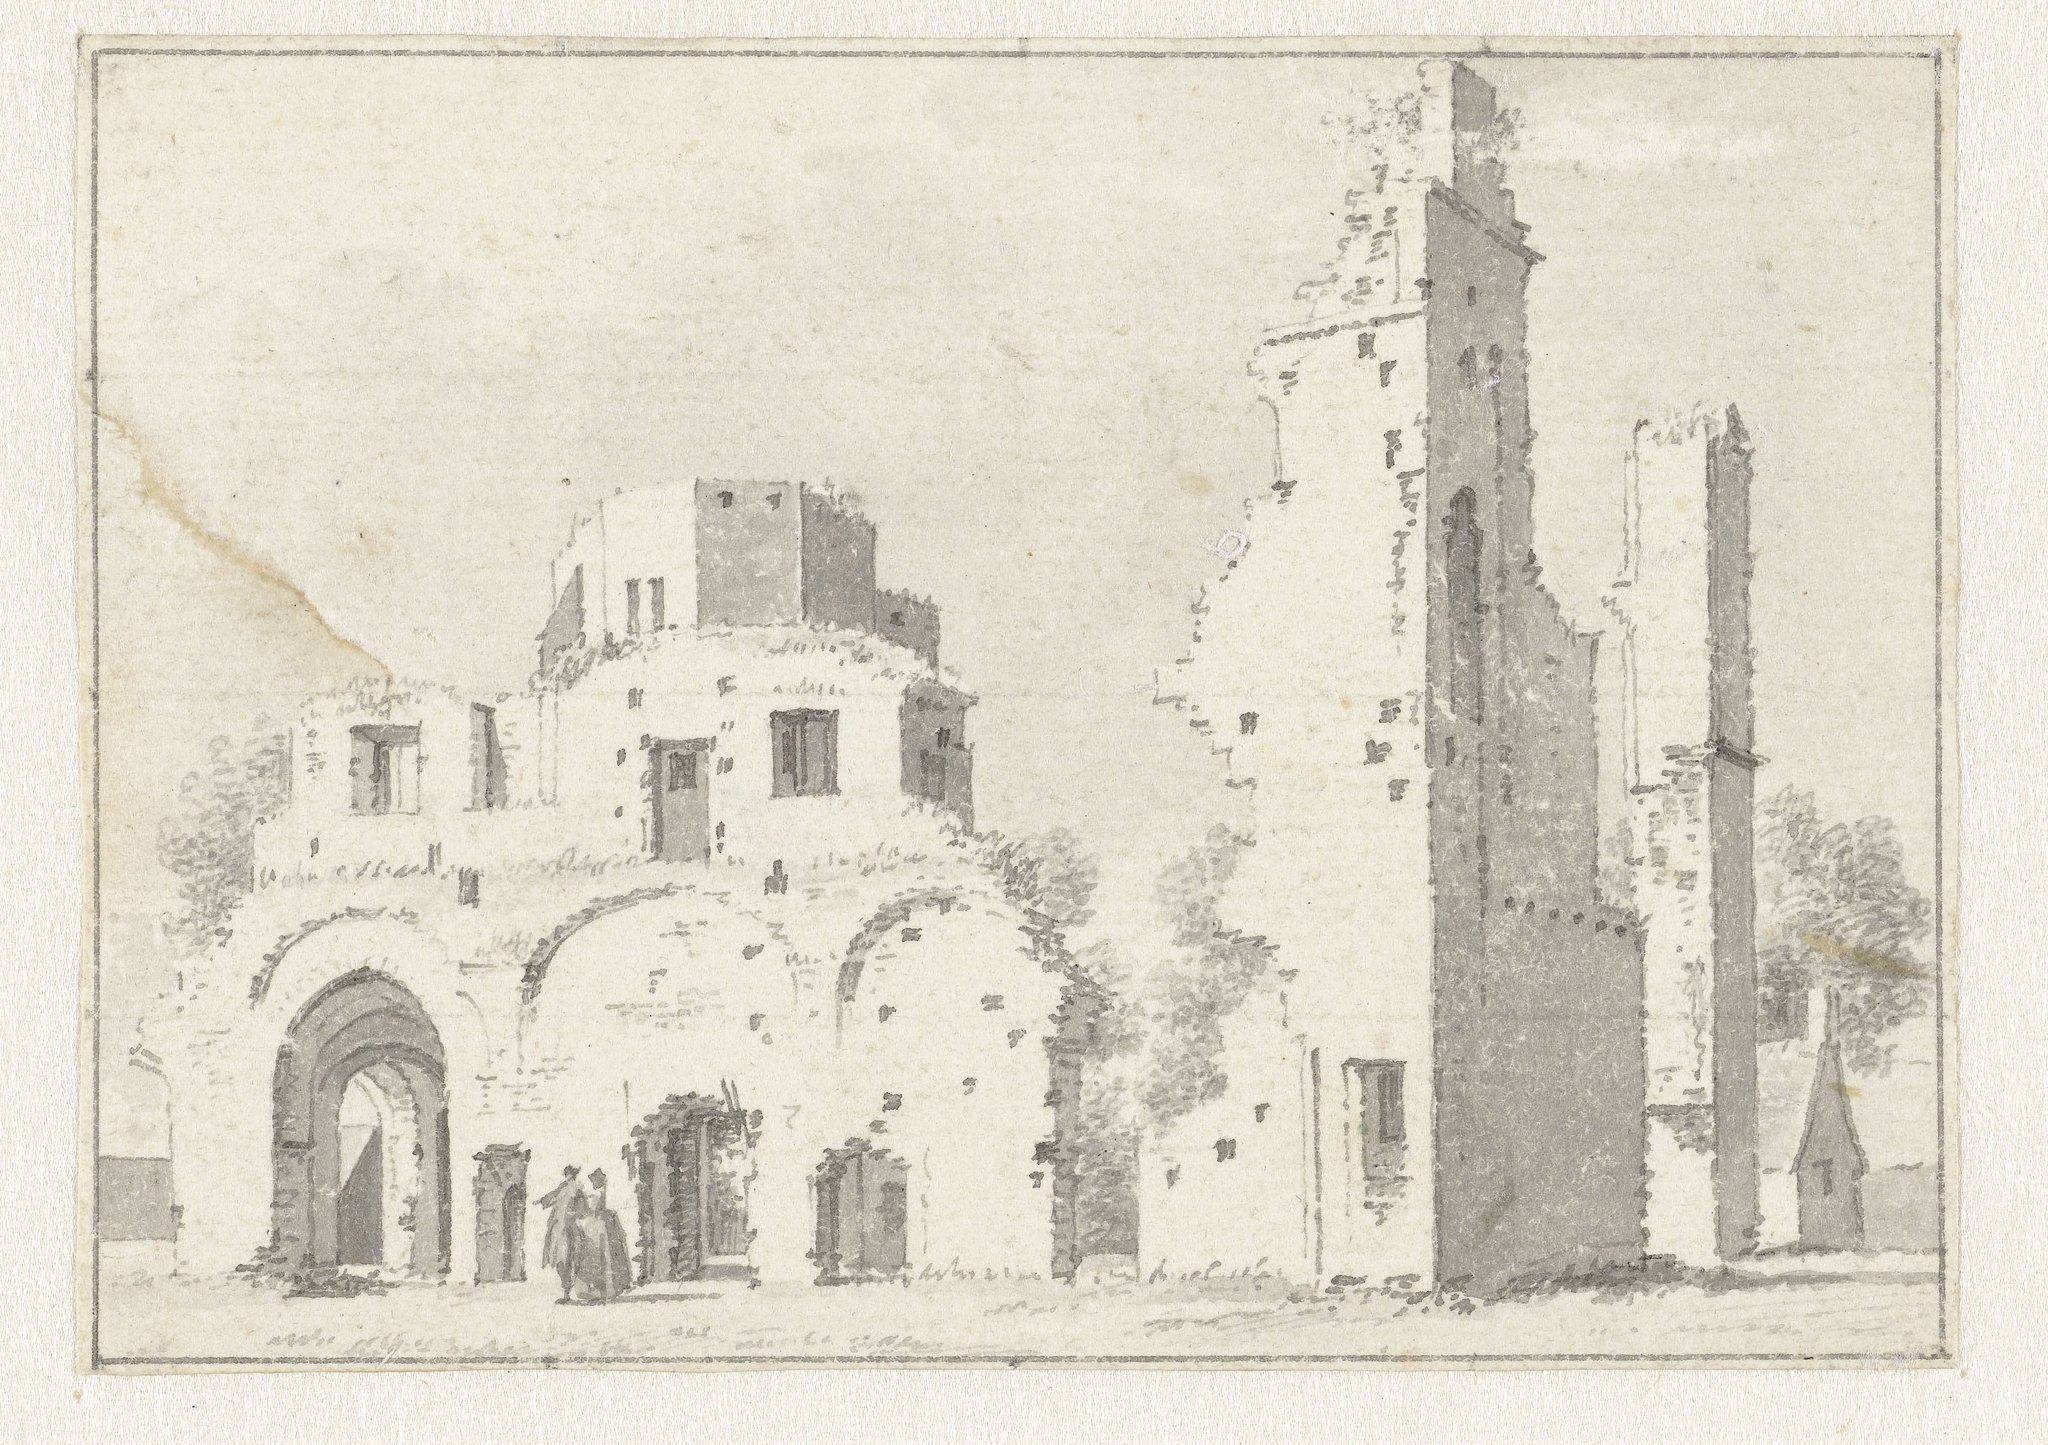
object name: drawing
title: De ruïne van de Abij te Rijnsburg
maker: cornelis pronk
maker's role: draughtsman, painter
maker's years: 1691-1759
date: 1725-1745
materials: ink, paper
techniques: brush, pen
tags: ruin of church, monastery, etc.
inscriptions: inscription: ‘Rijnsburg’